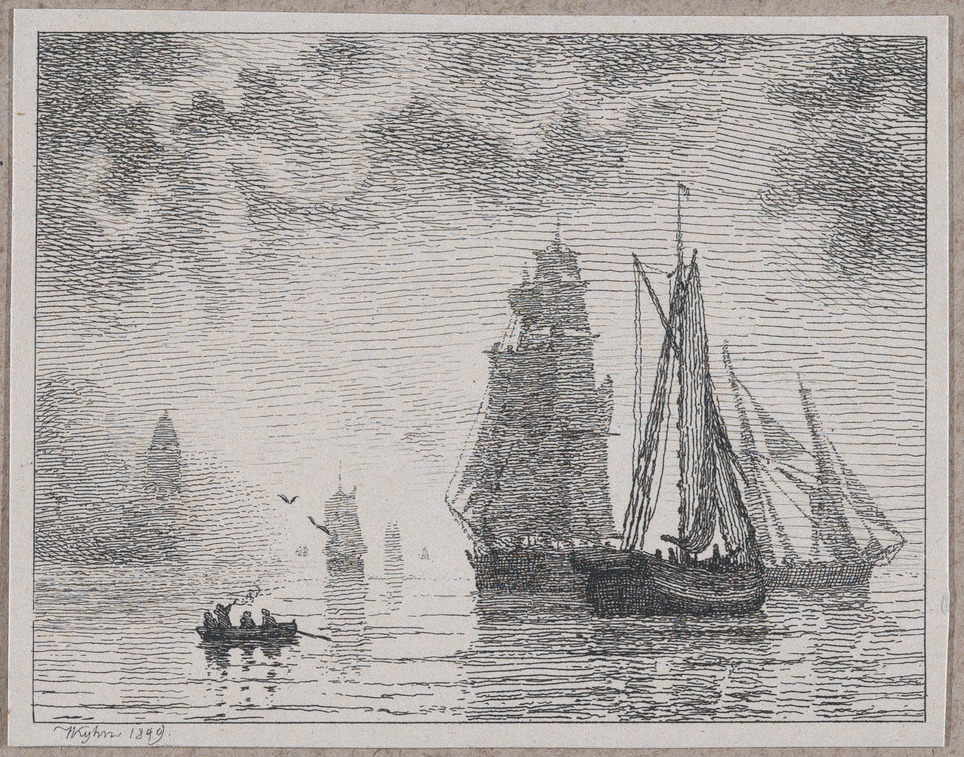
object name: print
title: Maritime View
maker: peter vilhelm carl kyhn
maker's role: artist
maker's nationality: danish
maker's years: 1819-1903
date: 1849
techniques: etching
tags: boats,ships